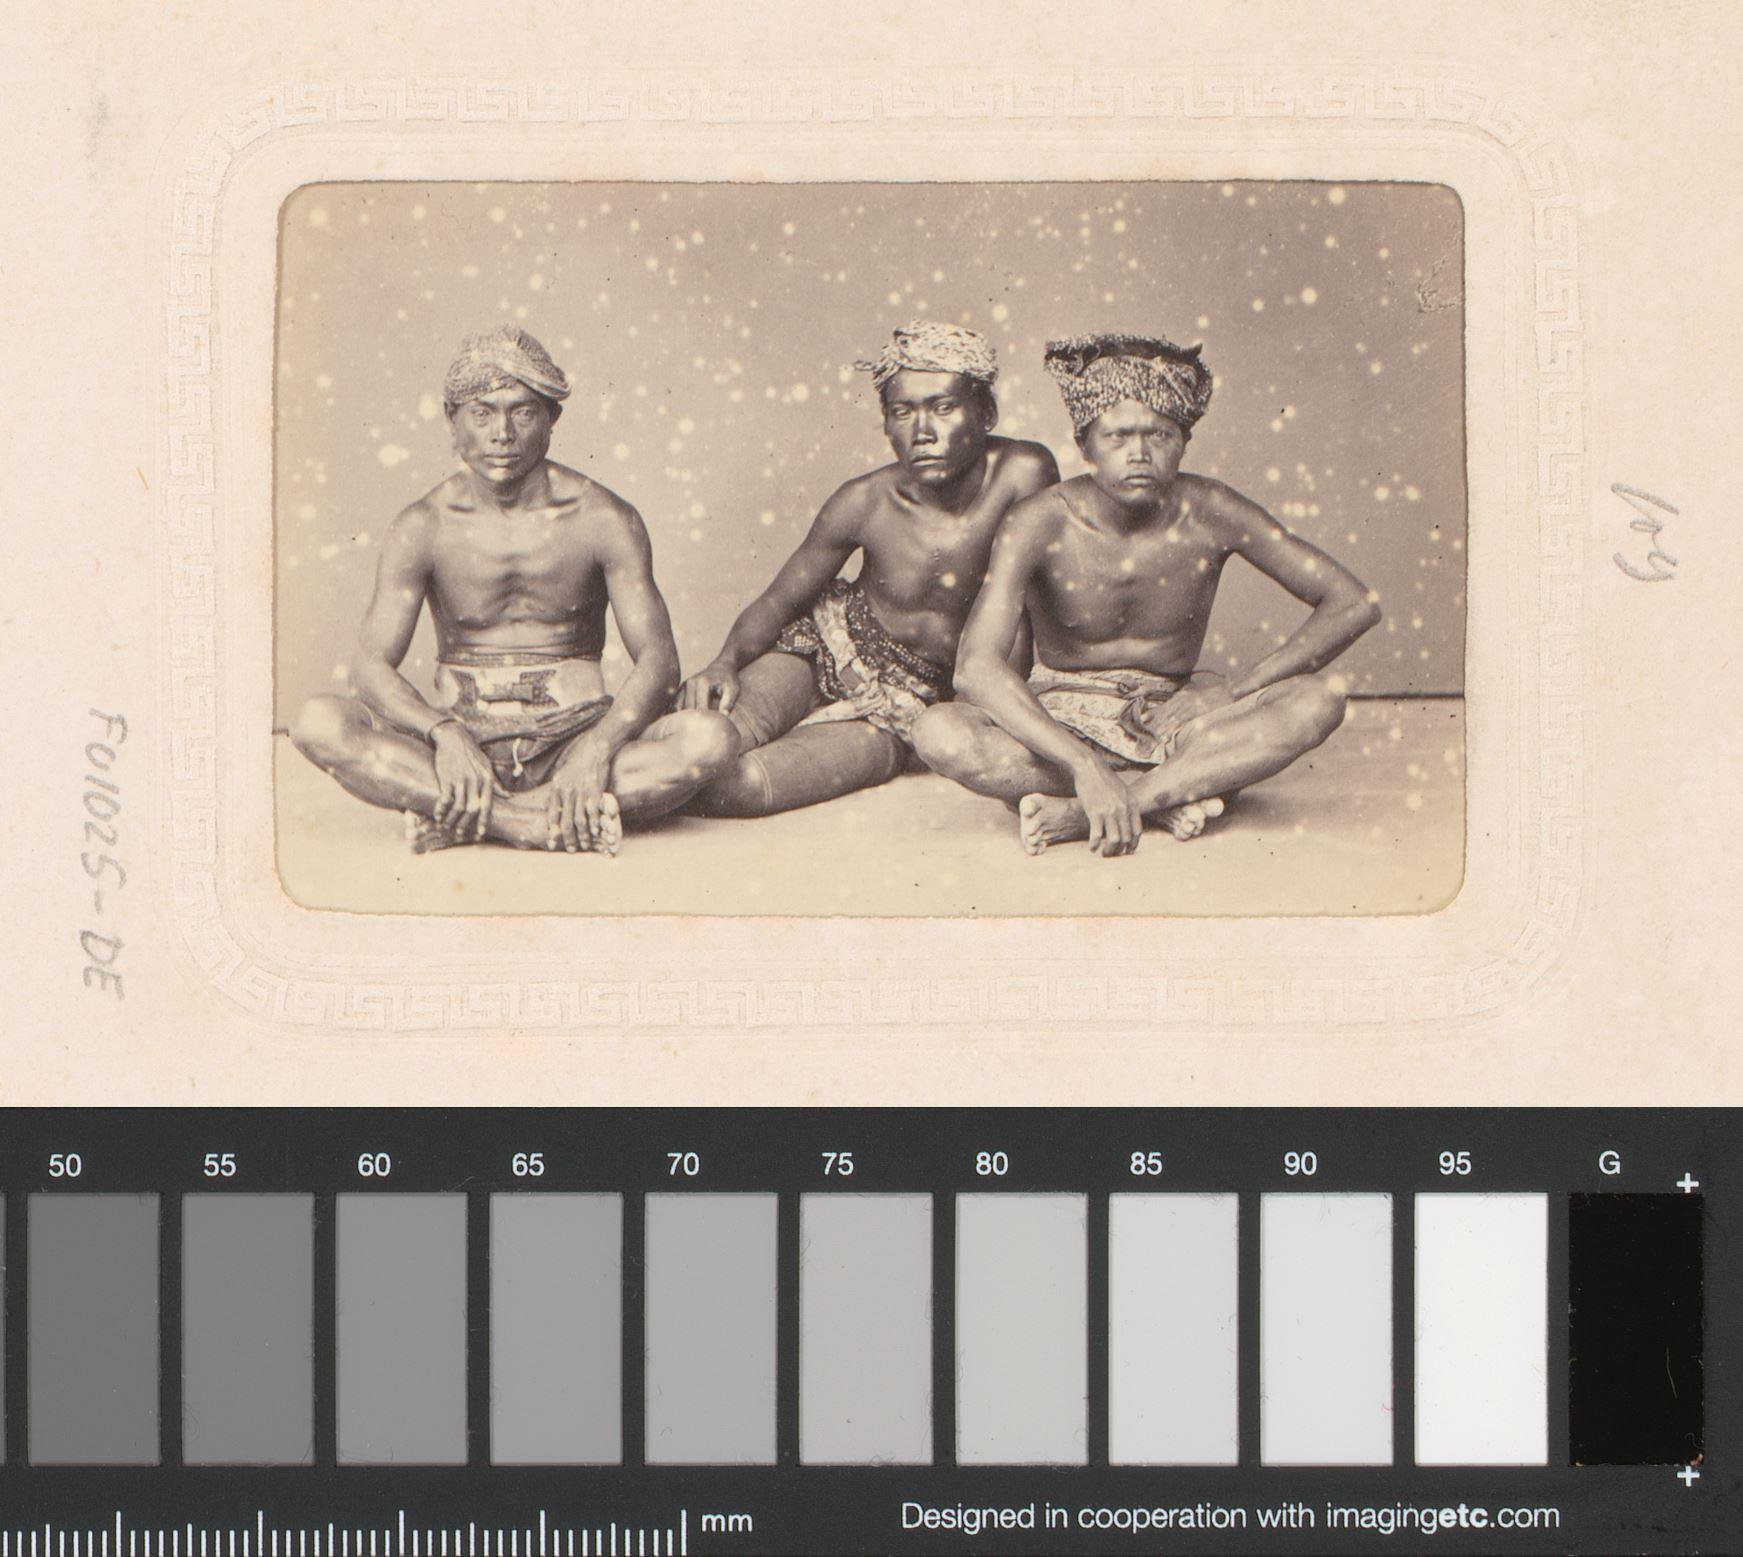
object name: carte de visite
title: Portret van drie Indonesische mannen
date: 1857-1880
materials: cardboard, photographic support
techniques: albumen print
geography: java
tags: sitting on the ground, anonymous historical persons portrayed in a group, in a group-portrait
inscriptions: number: ‘109’, inscription: ‘Woodbury & Page/ Photographers/ Java’